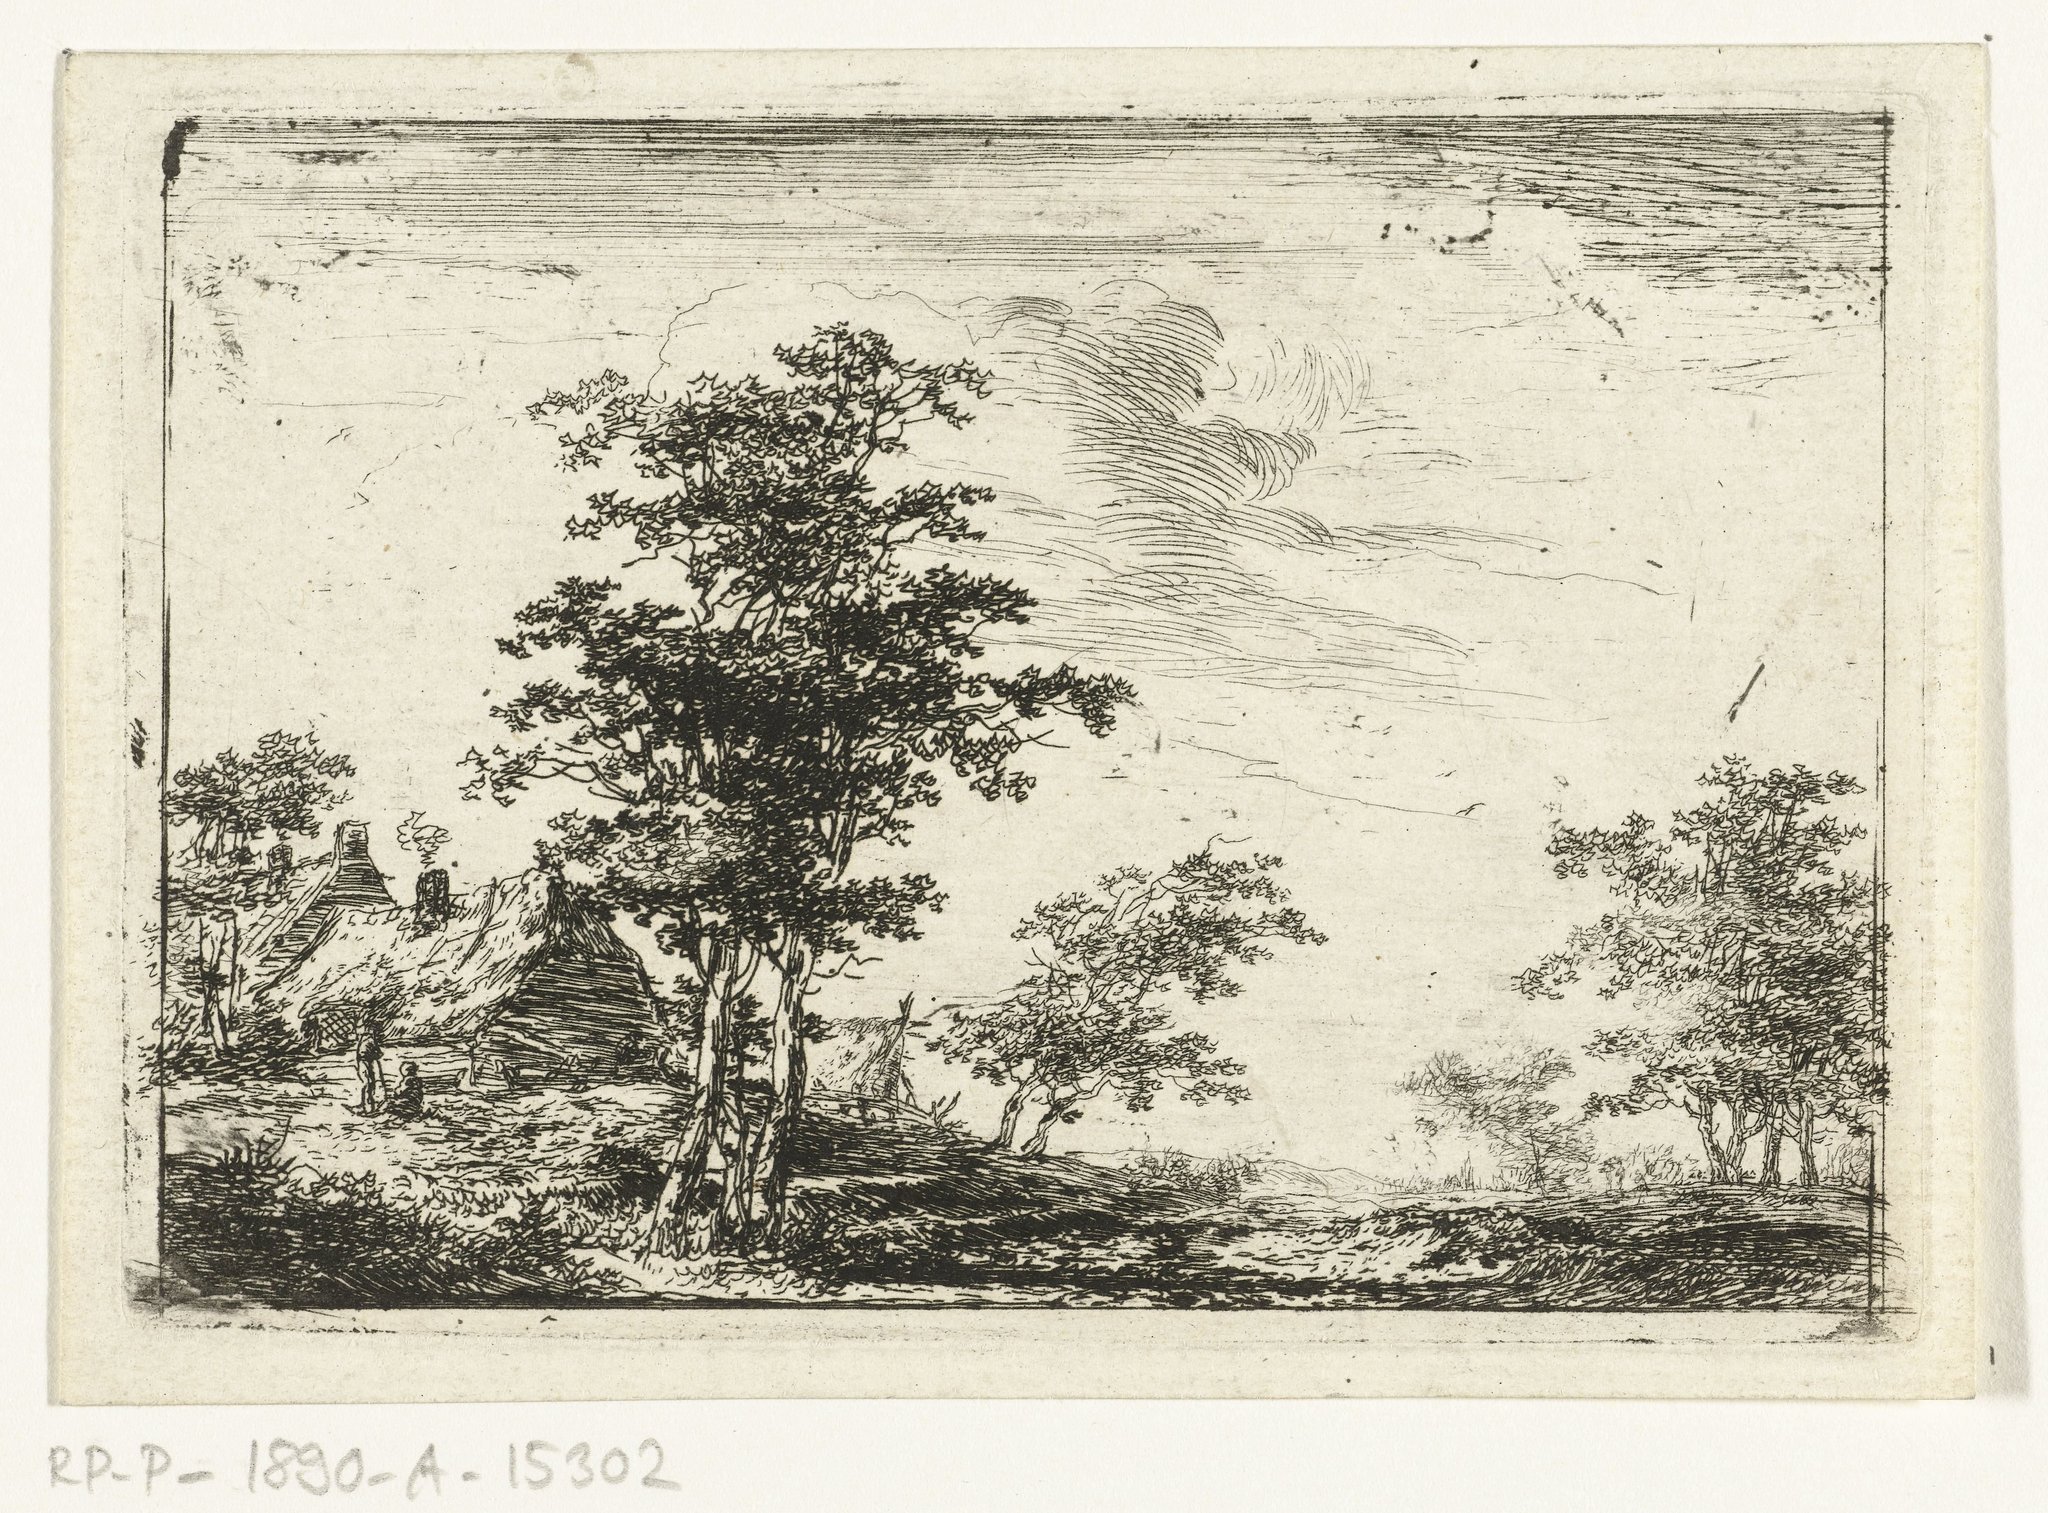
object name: print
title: Boerderij met rookende schoorsteen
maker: hermanus van brussel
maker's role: draughtsman, print maker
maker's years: 1763-1815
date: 1800-1815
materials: paper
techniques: drypoint, etching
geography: netherlands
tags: landscapes in the temperate zone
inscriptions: collector's mark: Lugt 2228